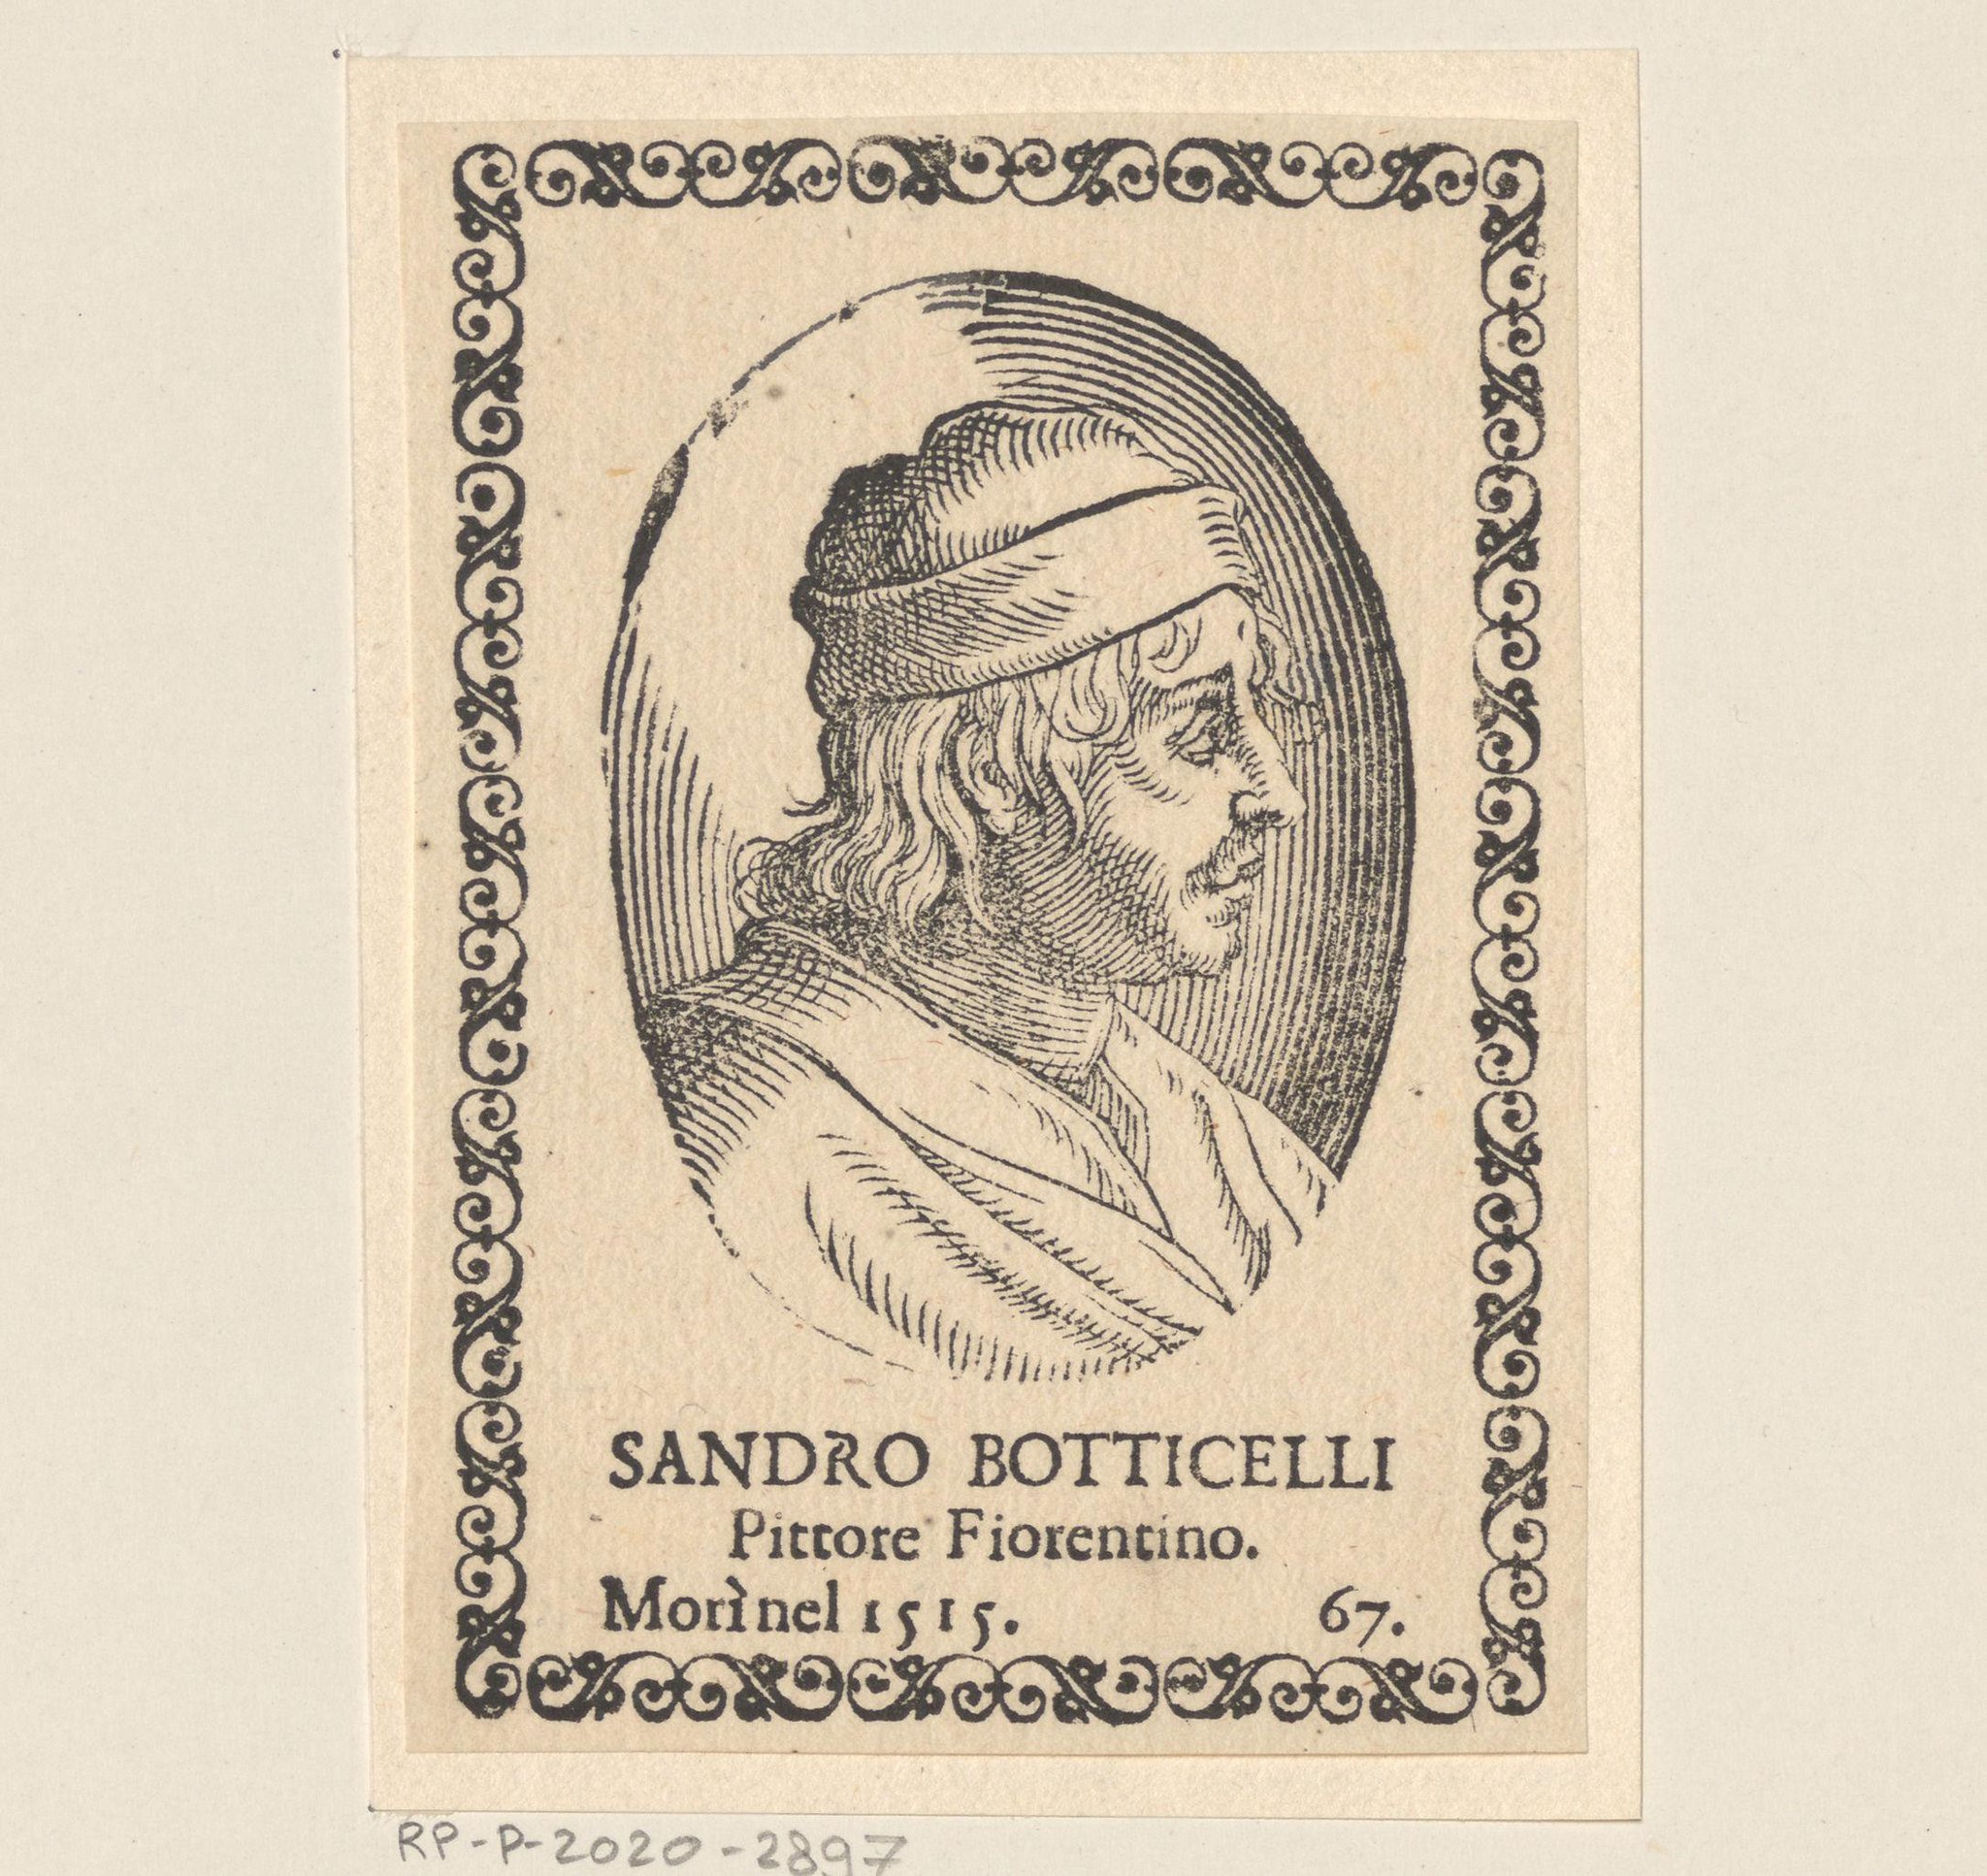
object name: print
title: Portret van Sandro Botticelli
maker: Anonymous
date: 1600-1699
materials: paper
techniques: letterpress printing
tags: painter, draughtsman, sandro botticelli, historical persons, portrait, self-portrait of painter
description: Prent waarschijnlijk afkomstig uit een Italiaanse editie van: Vasari, Giorgio. Vite de' più eccellenti architetti, pittori, et scultori italiani (...).